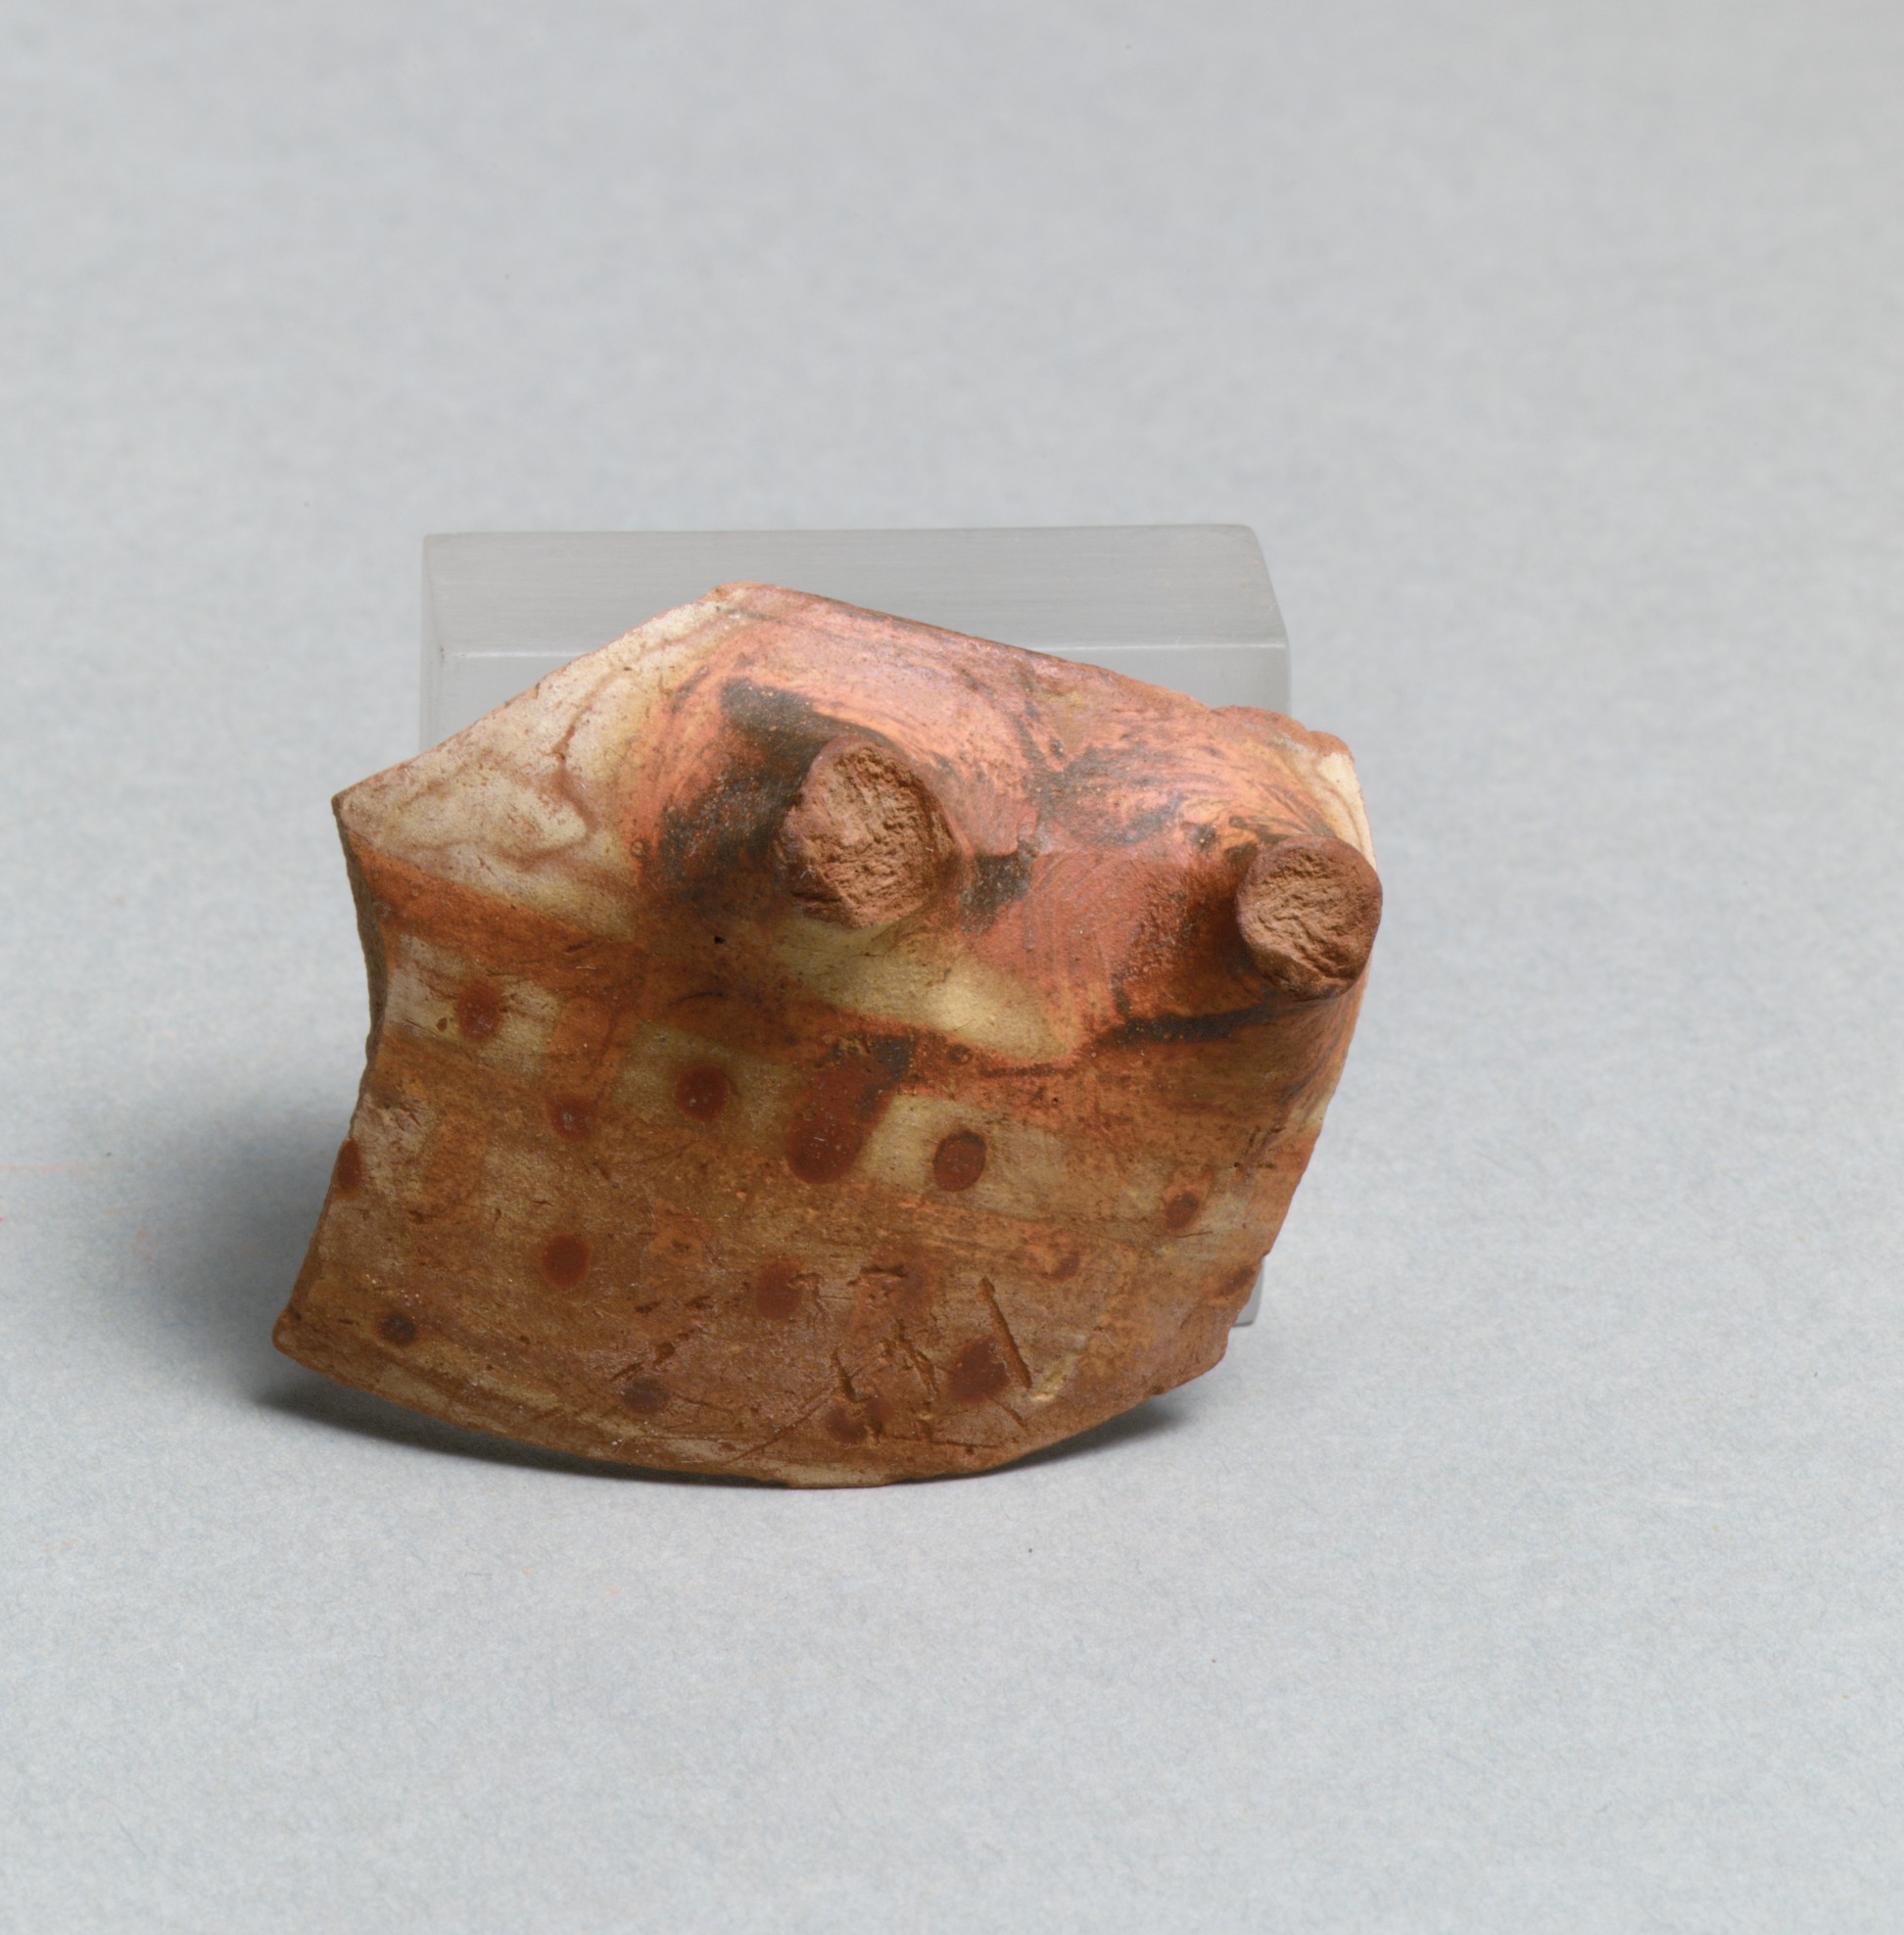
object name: vase fragment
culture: greek or lydian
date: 900-30 BCE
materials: terracotta